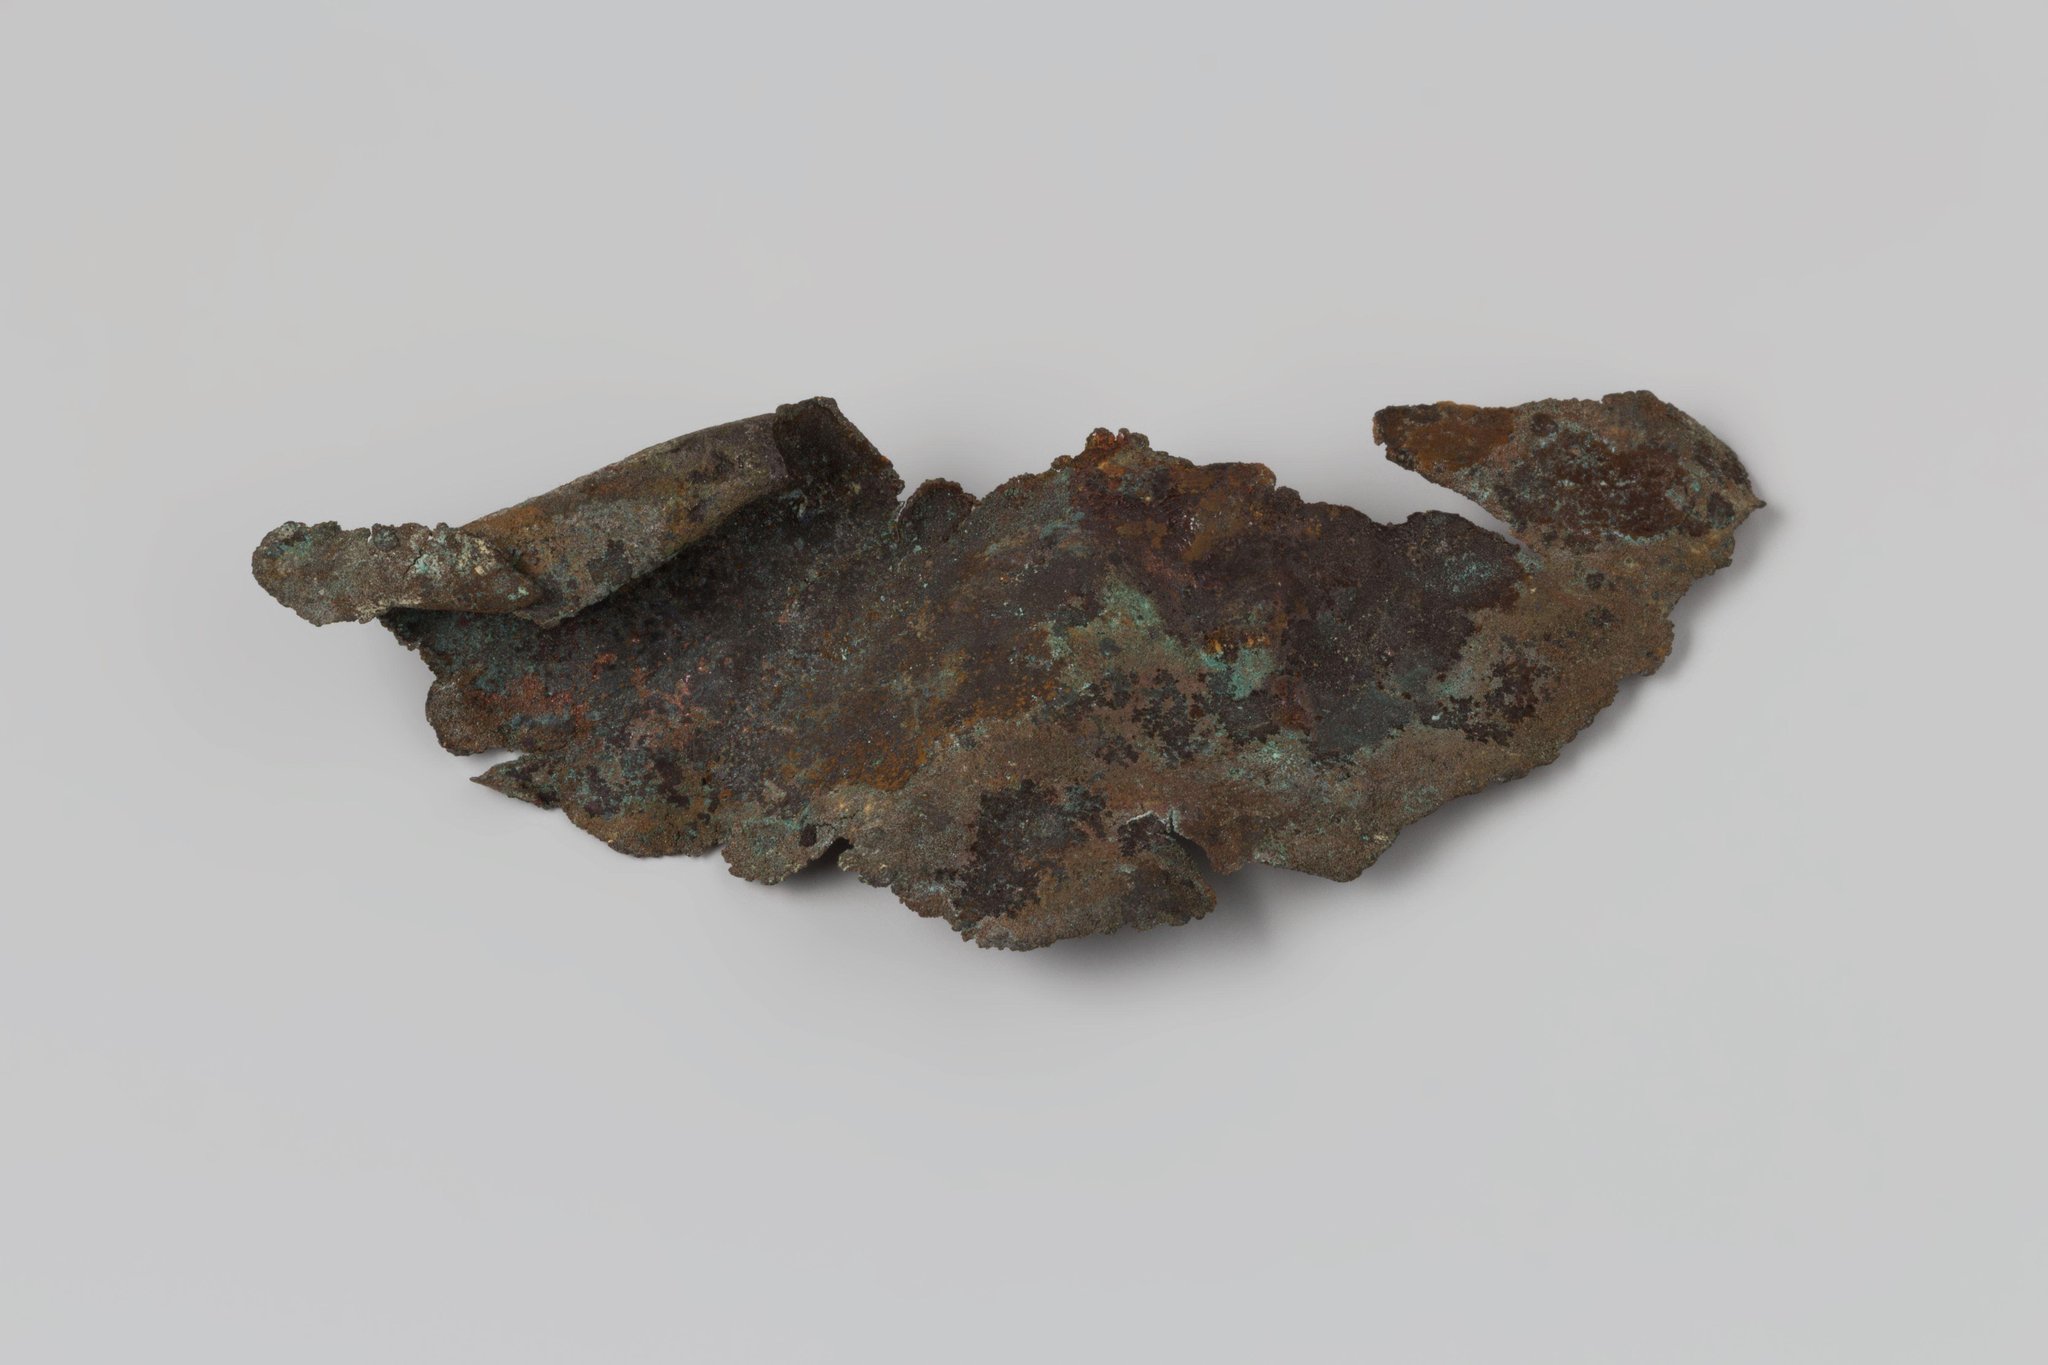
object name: scheepswrakvondst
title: Fragment van koper uit het wrak van de Oost-Indiëvaarder Hollandia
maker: Anonymous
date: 1700-1743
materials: copper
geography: netherlands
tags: verenigde oostindische compagnie, hollandia (schip), annet